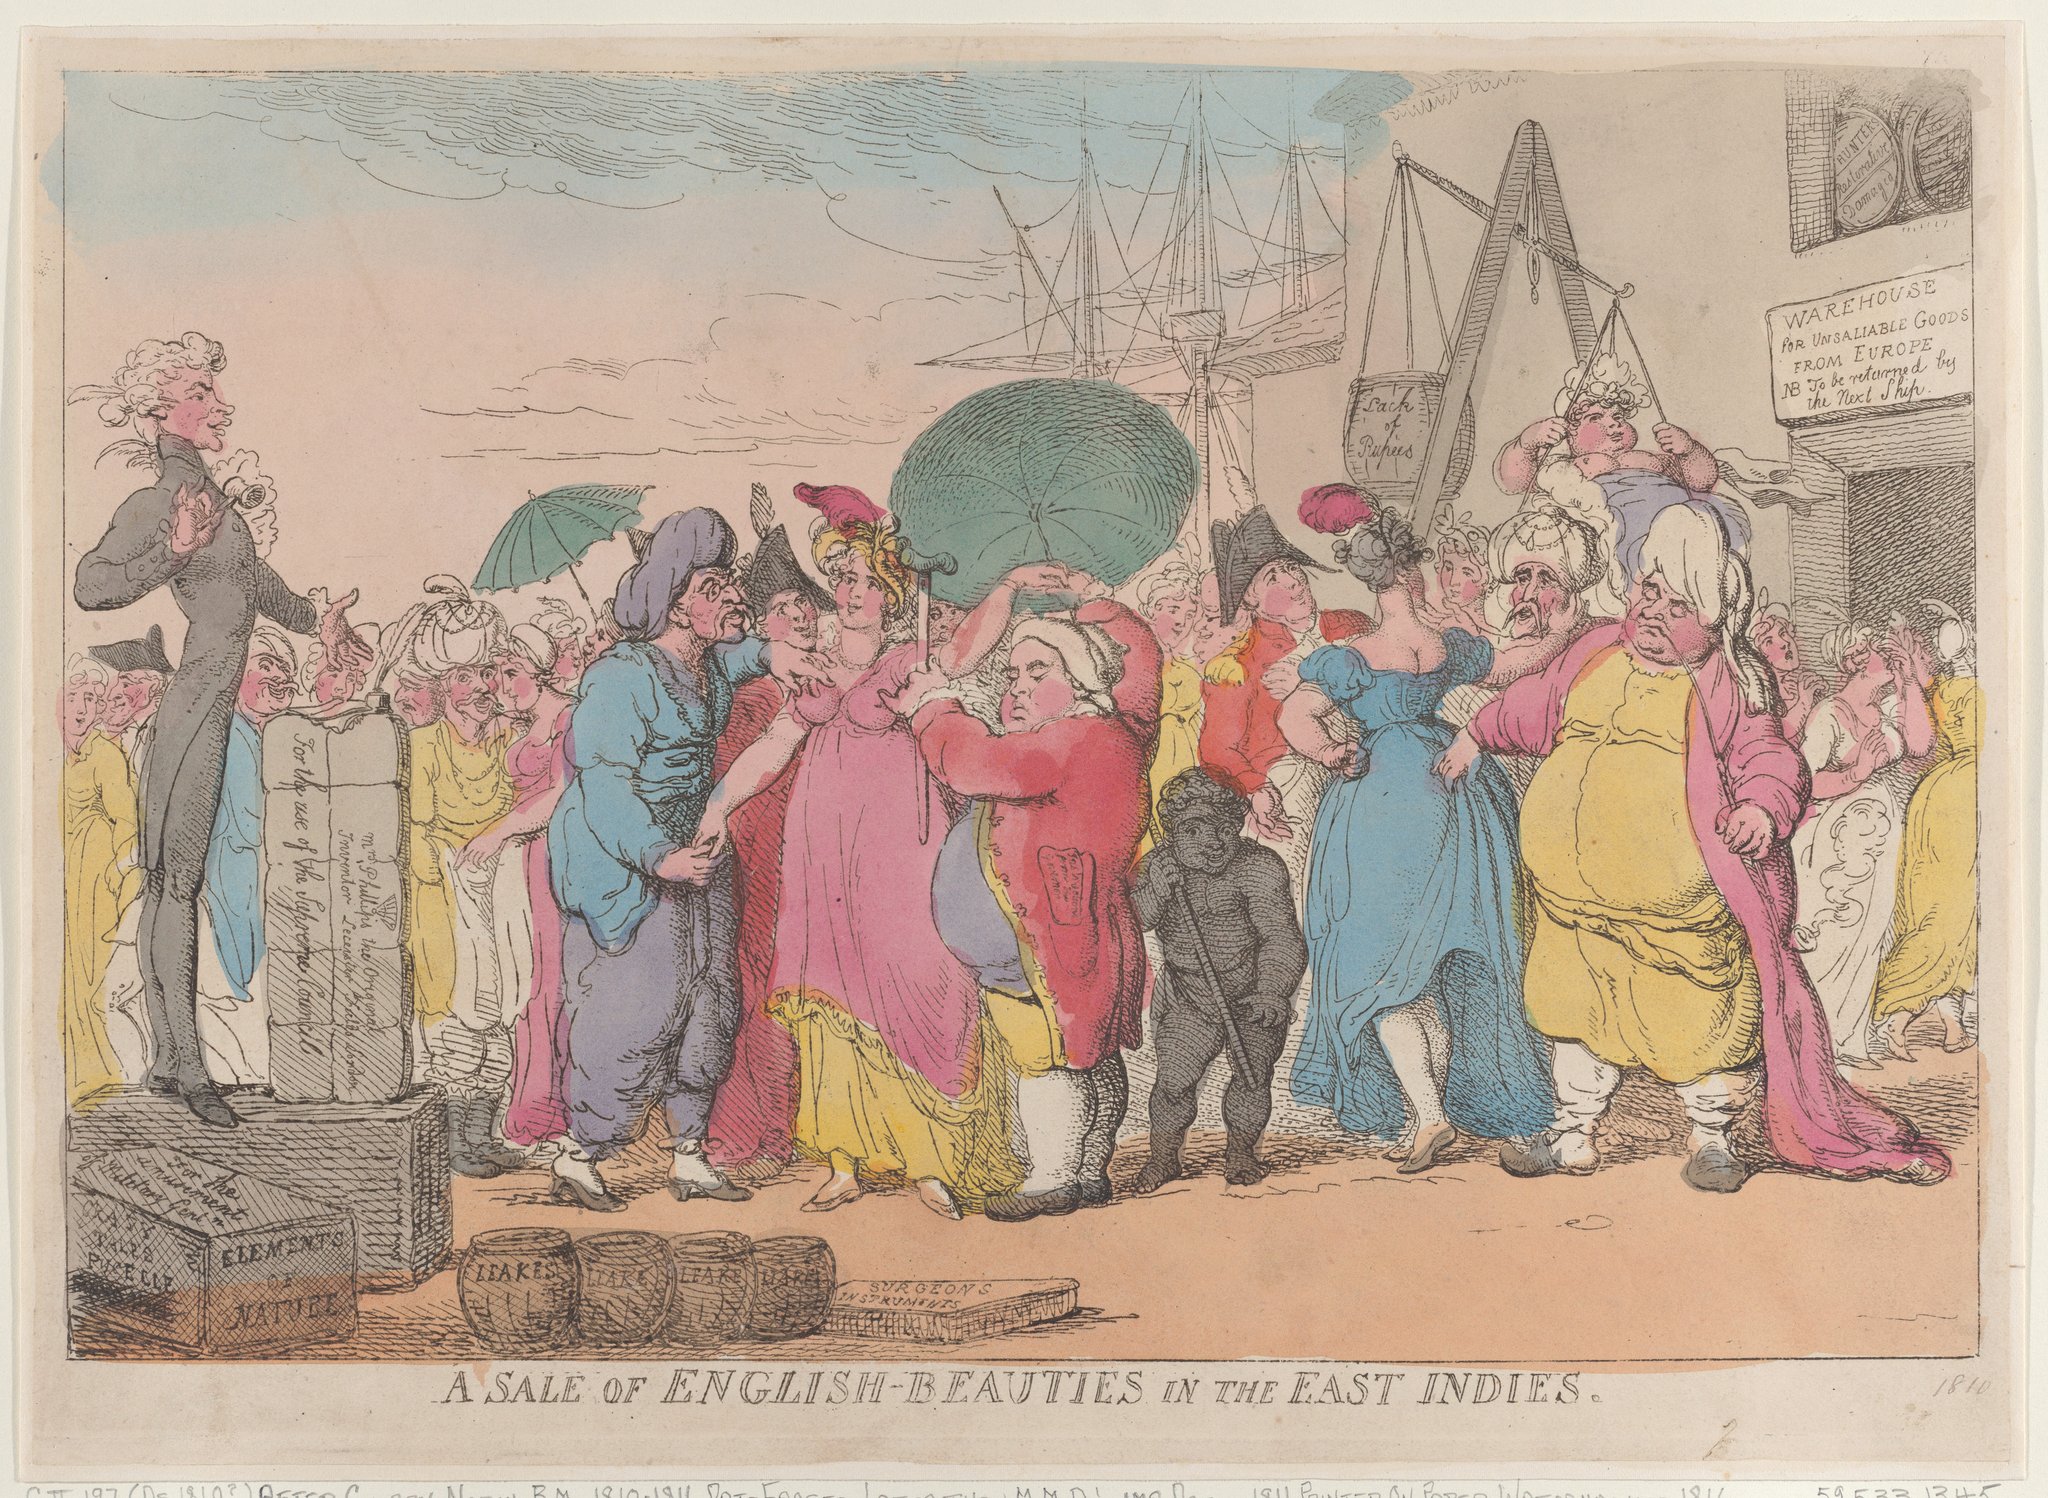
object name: print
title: A Sale of English-Beauties in the East Indies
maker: thomas rowlandson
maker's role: artist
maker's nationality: british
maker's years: 1757-1827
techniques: etching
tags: satire,men,women